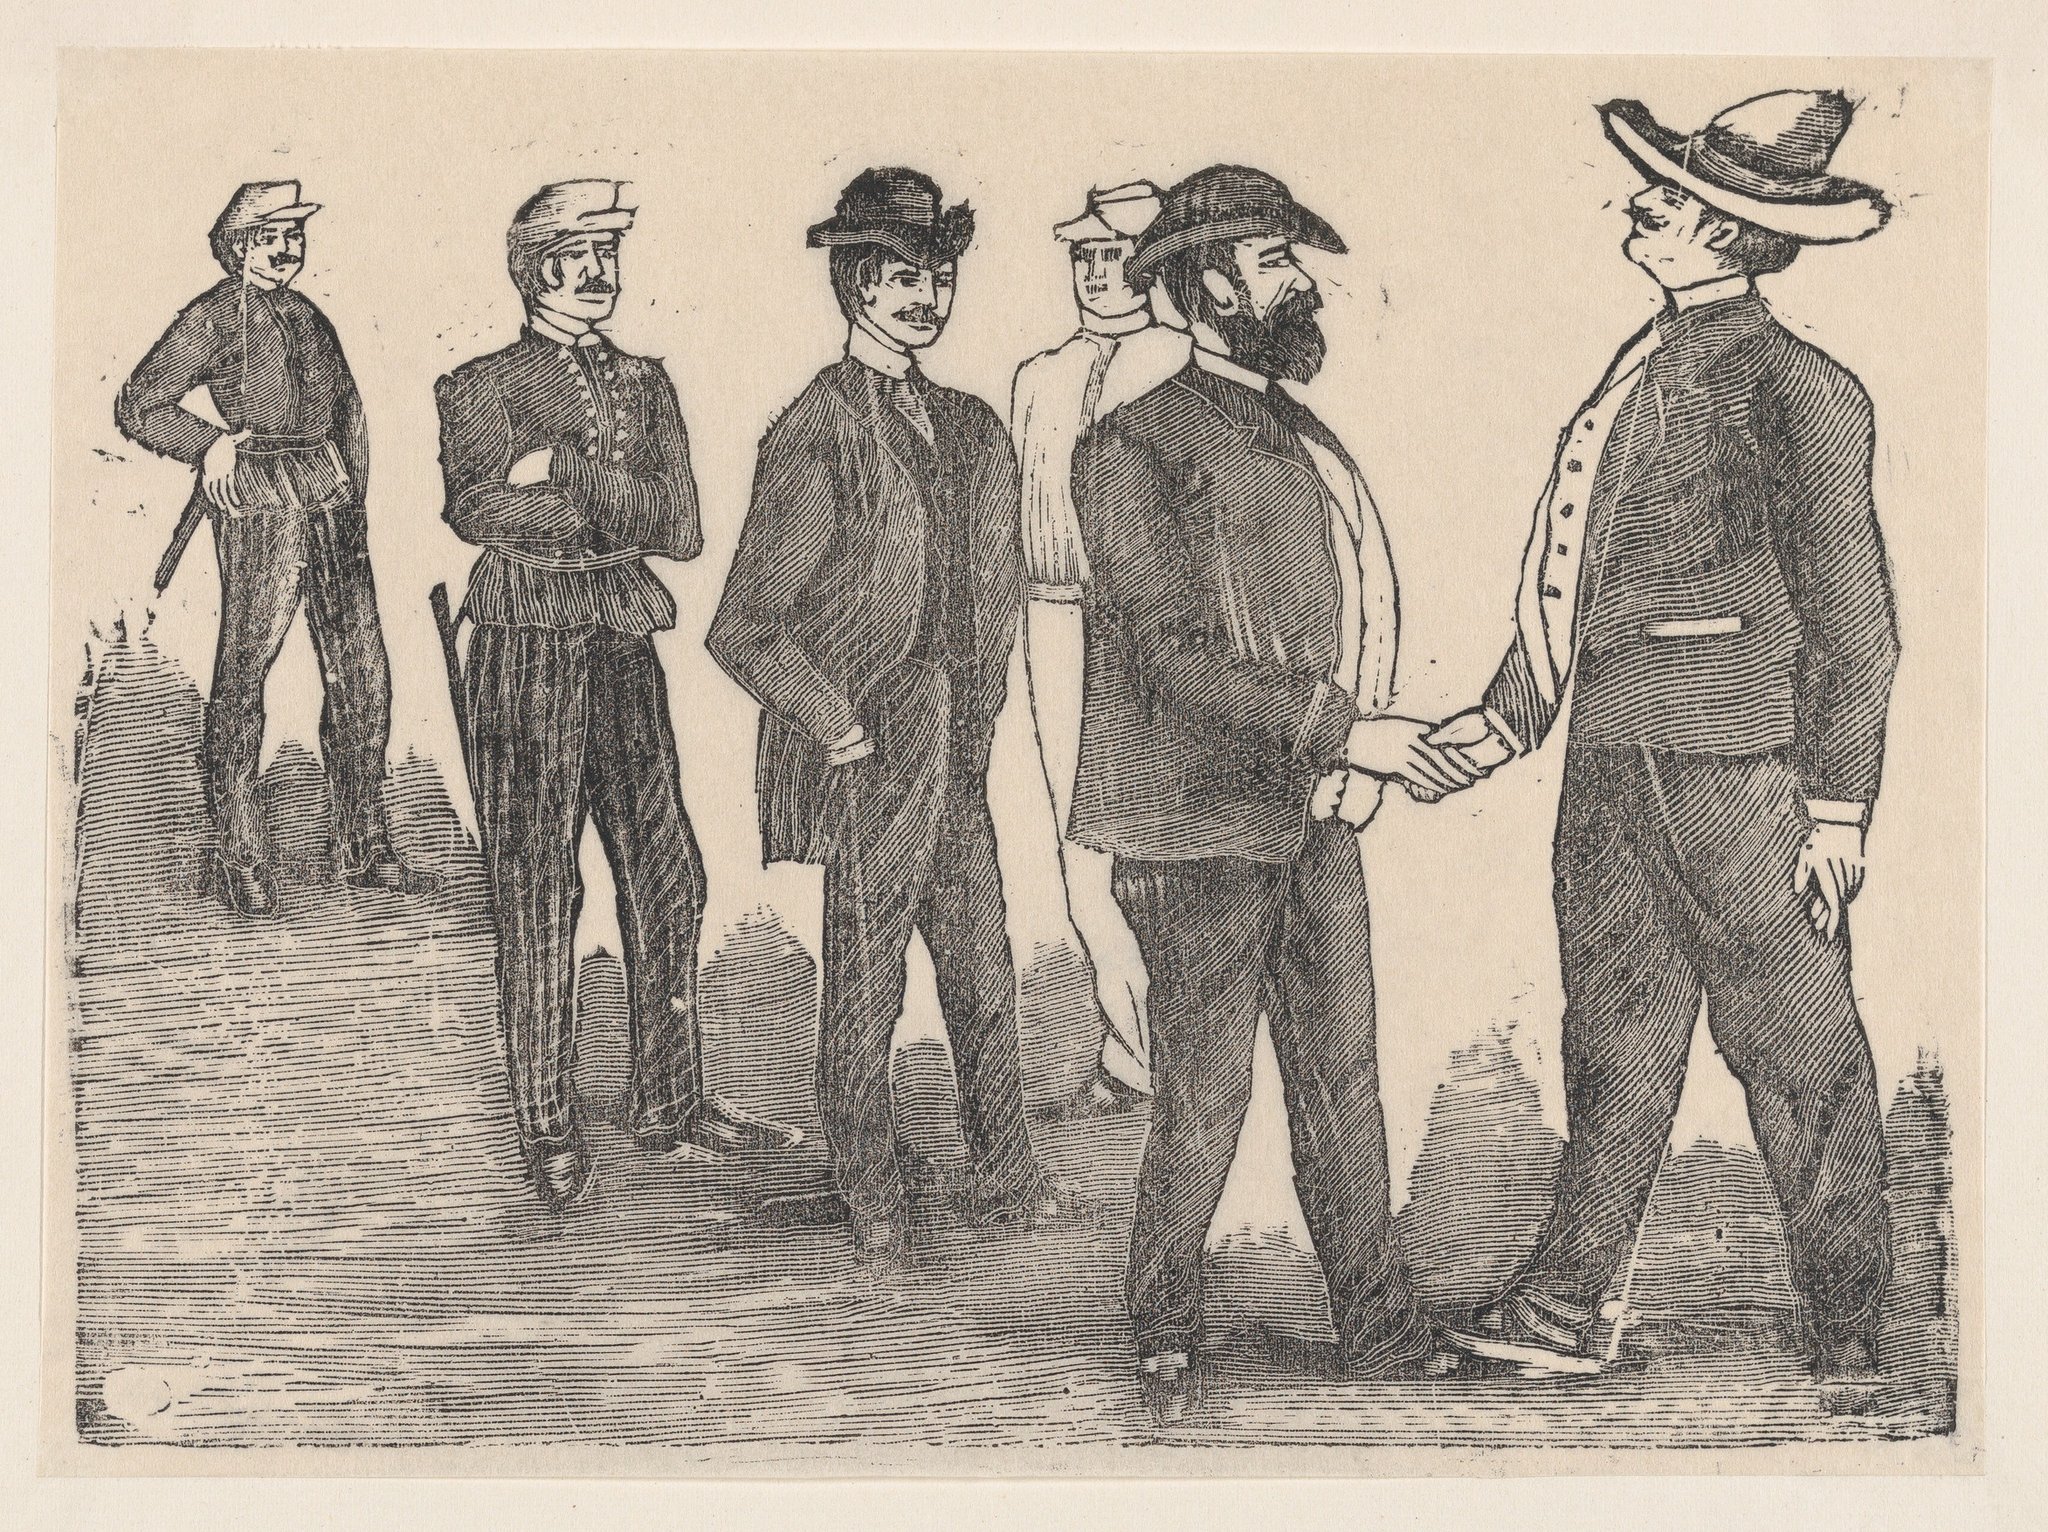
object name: print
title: Two men shaking hands in the foreground and officers watching them in the background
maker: josé guadalupe posada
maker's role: artist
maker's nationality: mexican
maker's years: 1852-1913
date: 1880-1910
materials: metal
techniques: engraving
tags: men